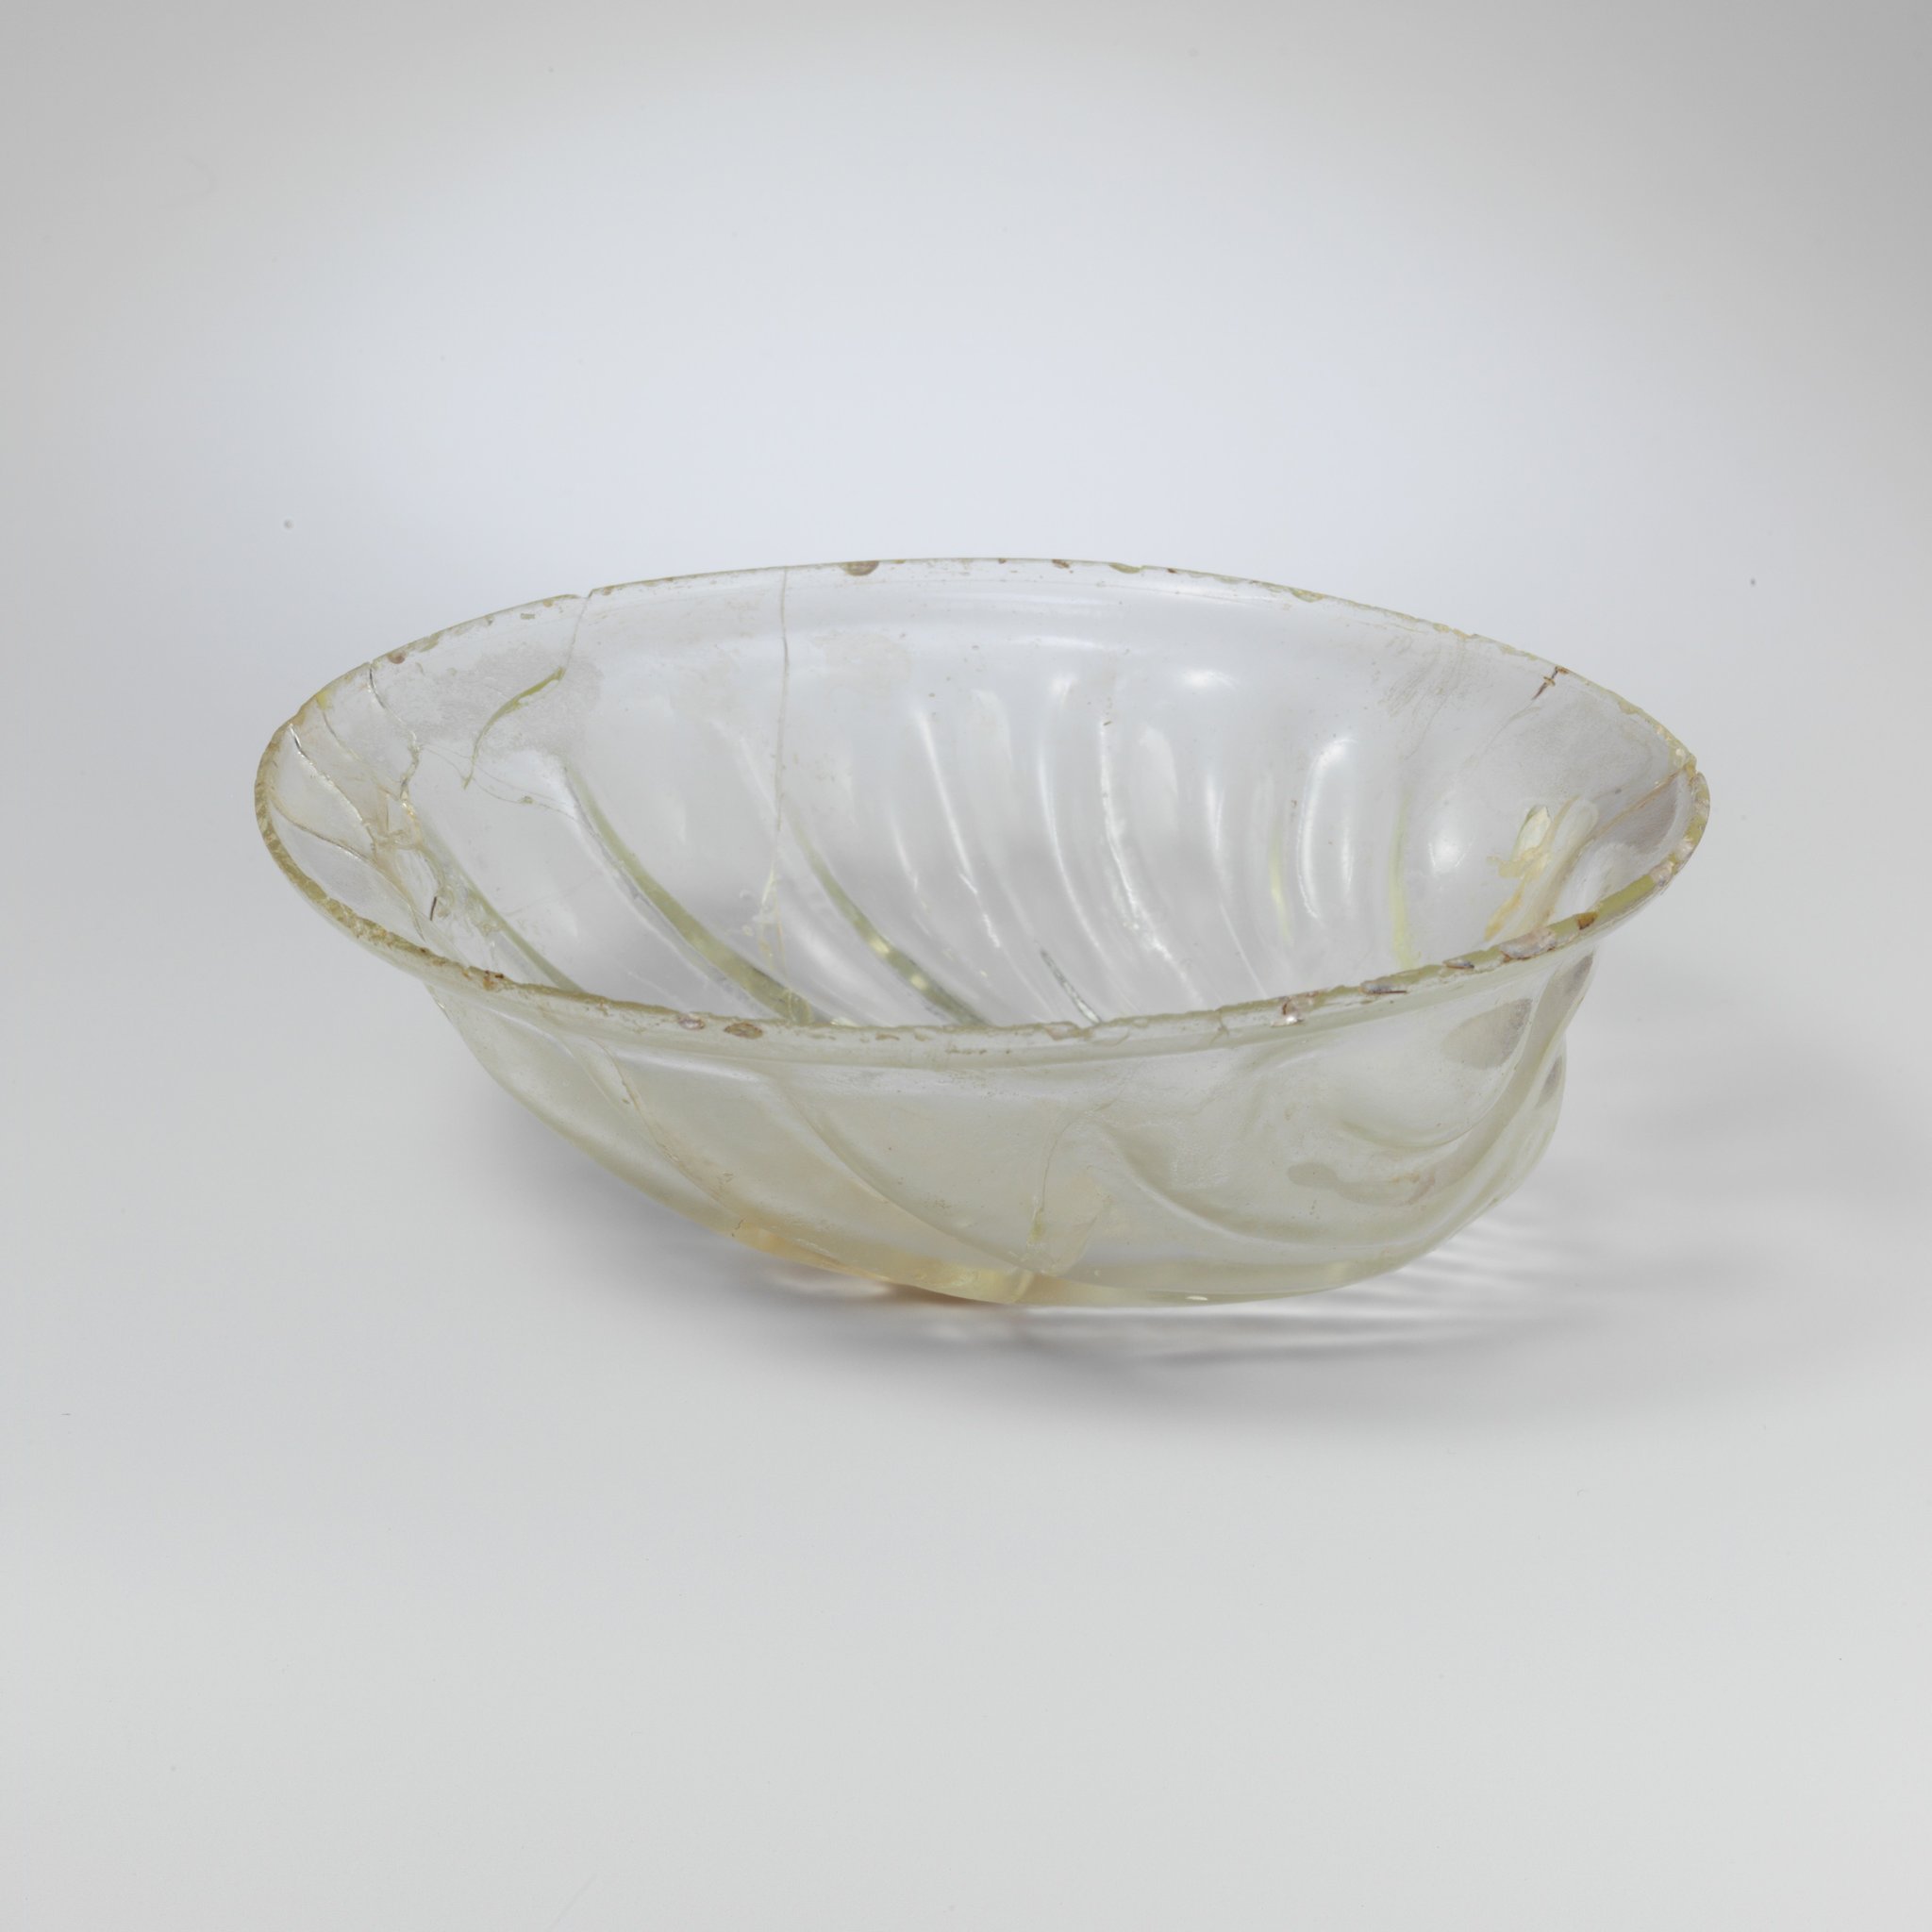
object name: bowl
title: Glass bowl in the form of a shell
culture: roman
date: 301-350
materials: glass